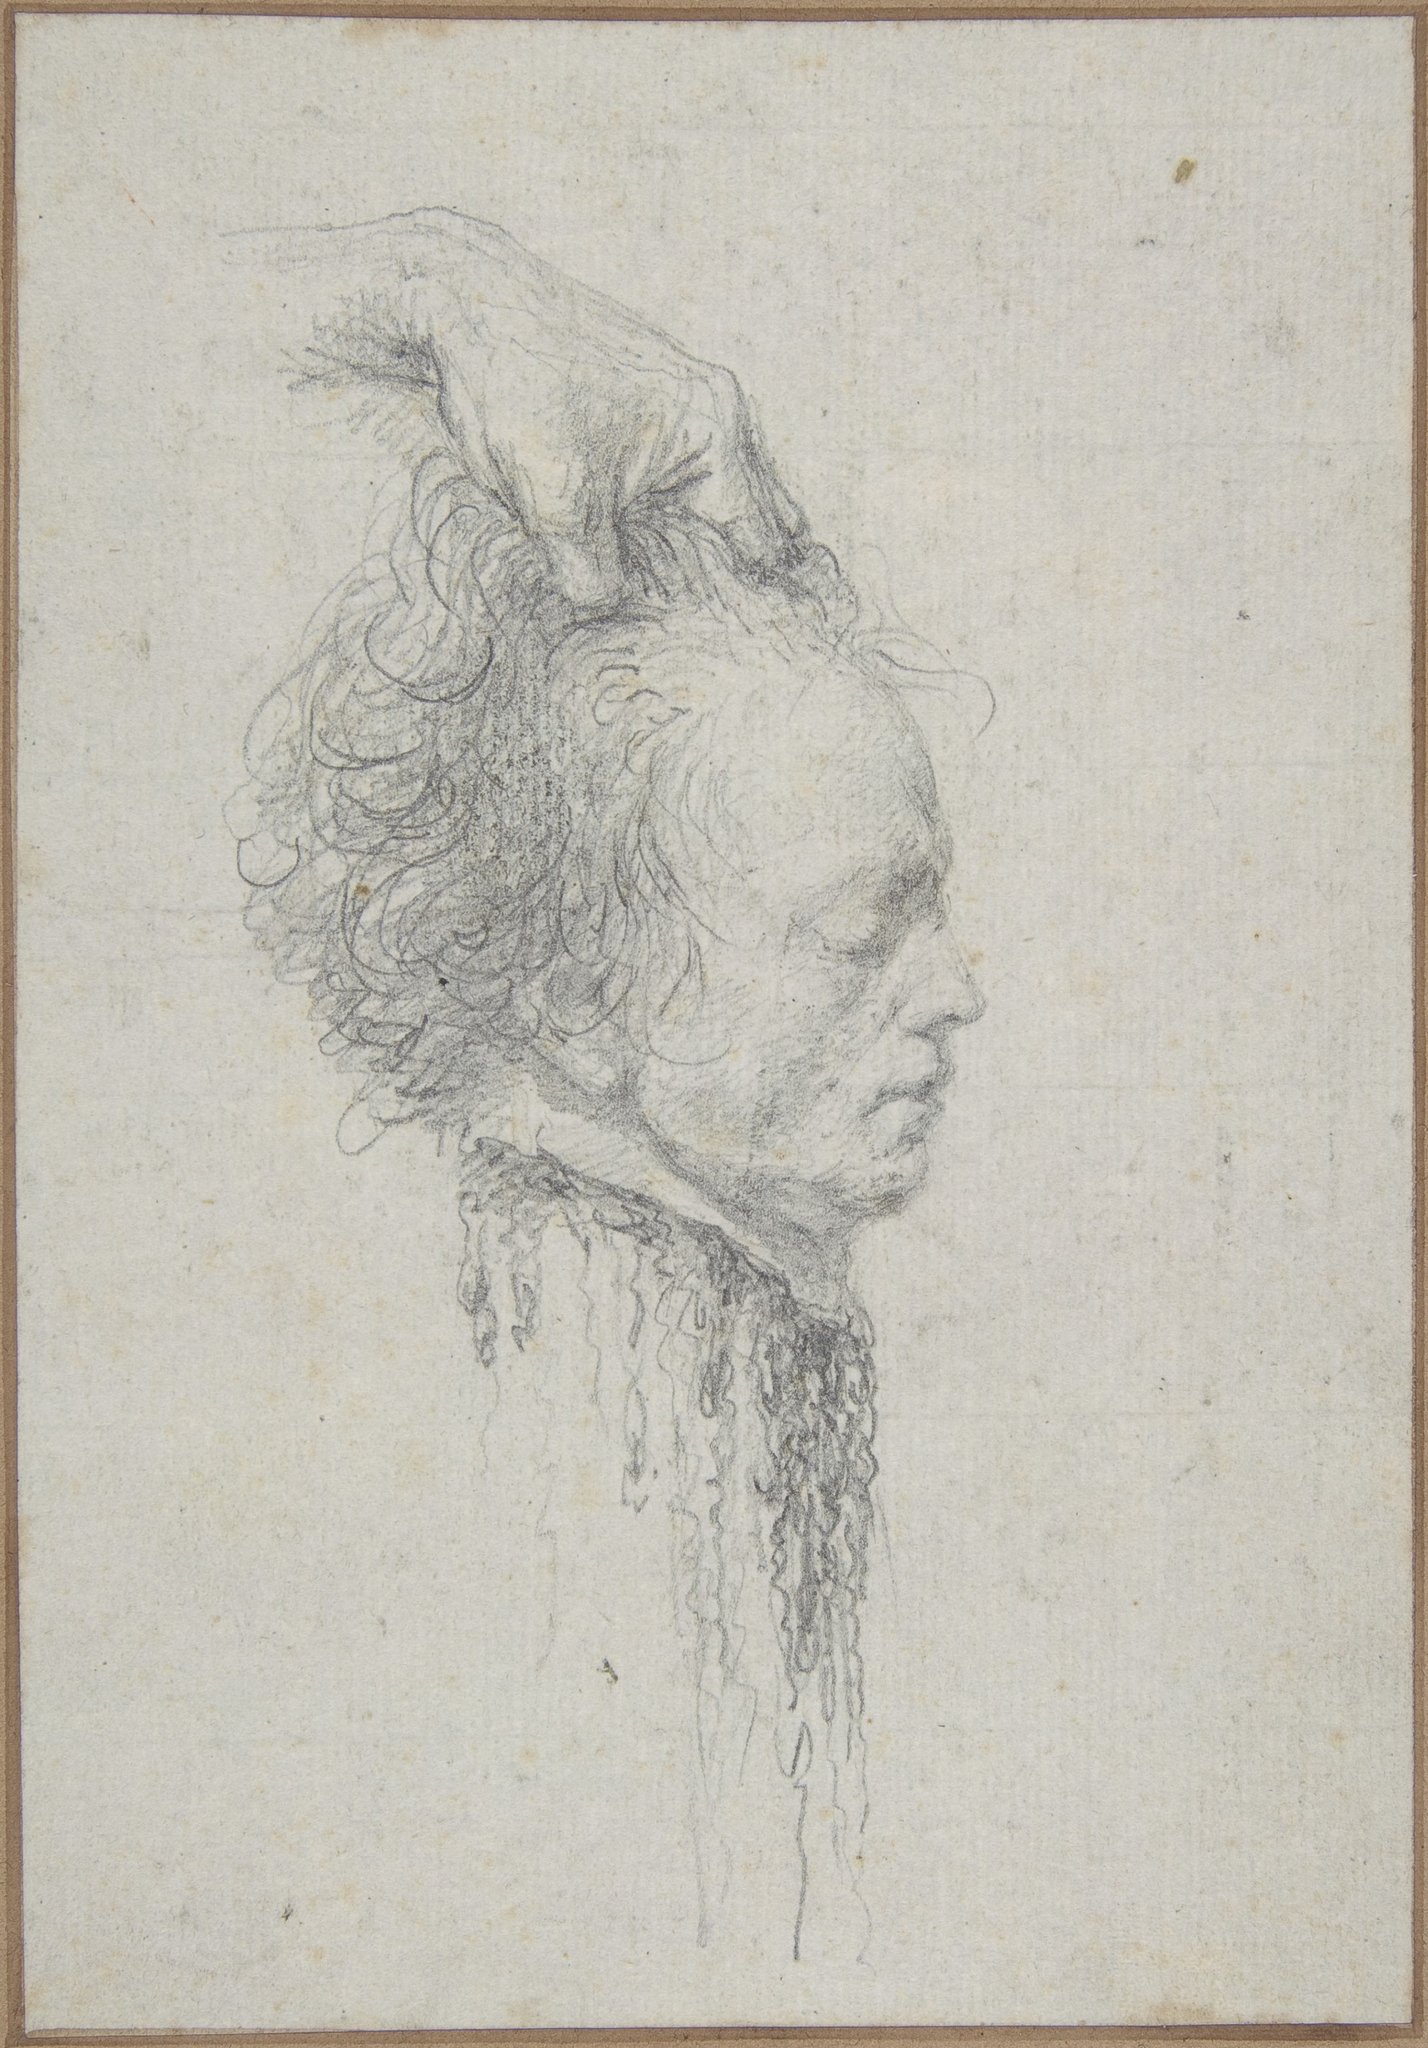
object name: drawing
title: Severed head, said to be that of Maximilien-François-Marie-Isidore de Robespierre (1758-1794), guillotined July 28, 1794 (10 Thermidor, An II)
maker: baron dominique vivant denon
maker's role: artist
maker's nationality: french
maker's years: 1747-1825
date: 1794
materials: graphite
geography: france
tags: hands,heads